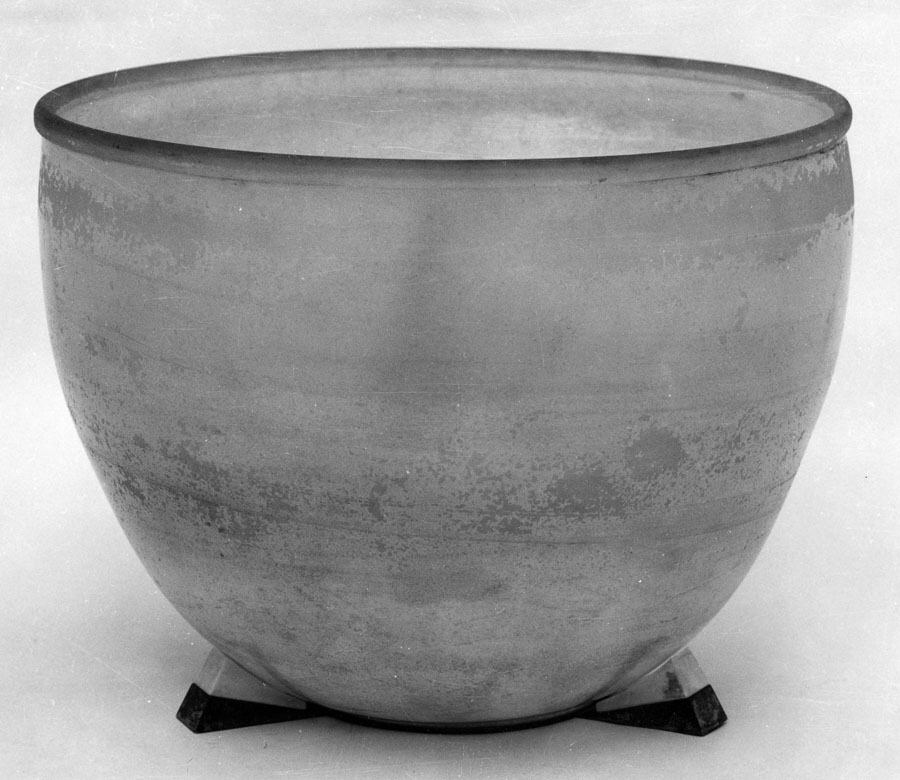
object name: bowl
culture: chinese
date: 618-1279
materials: glass